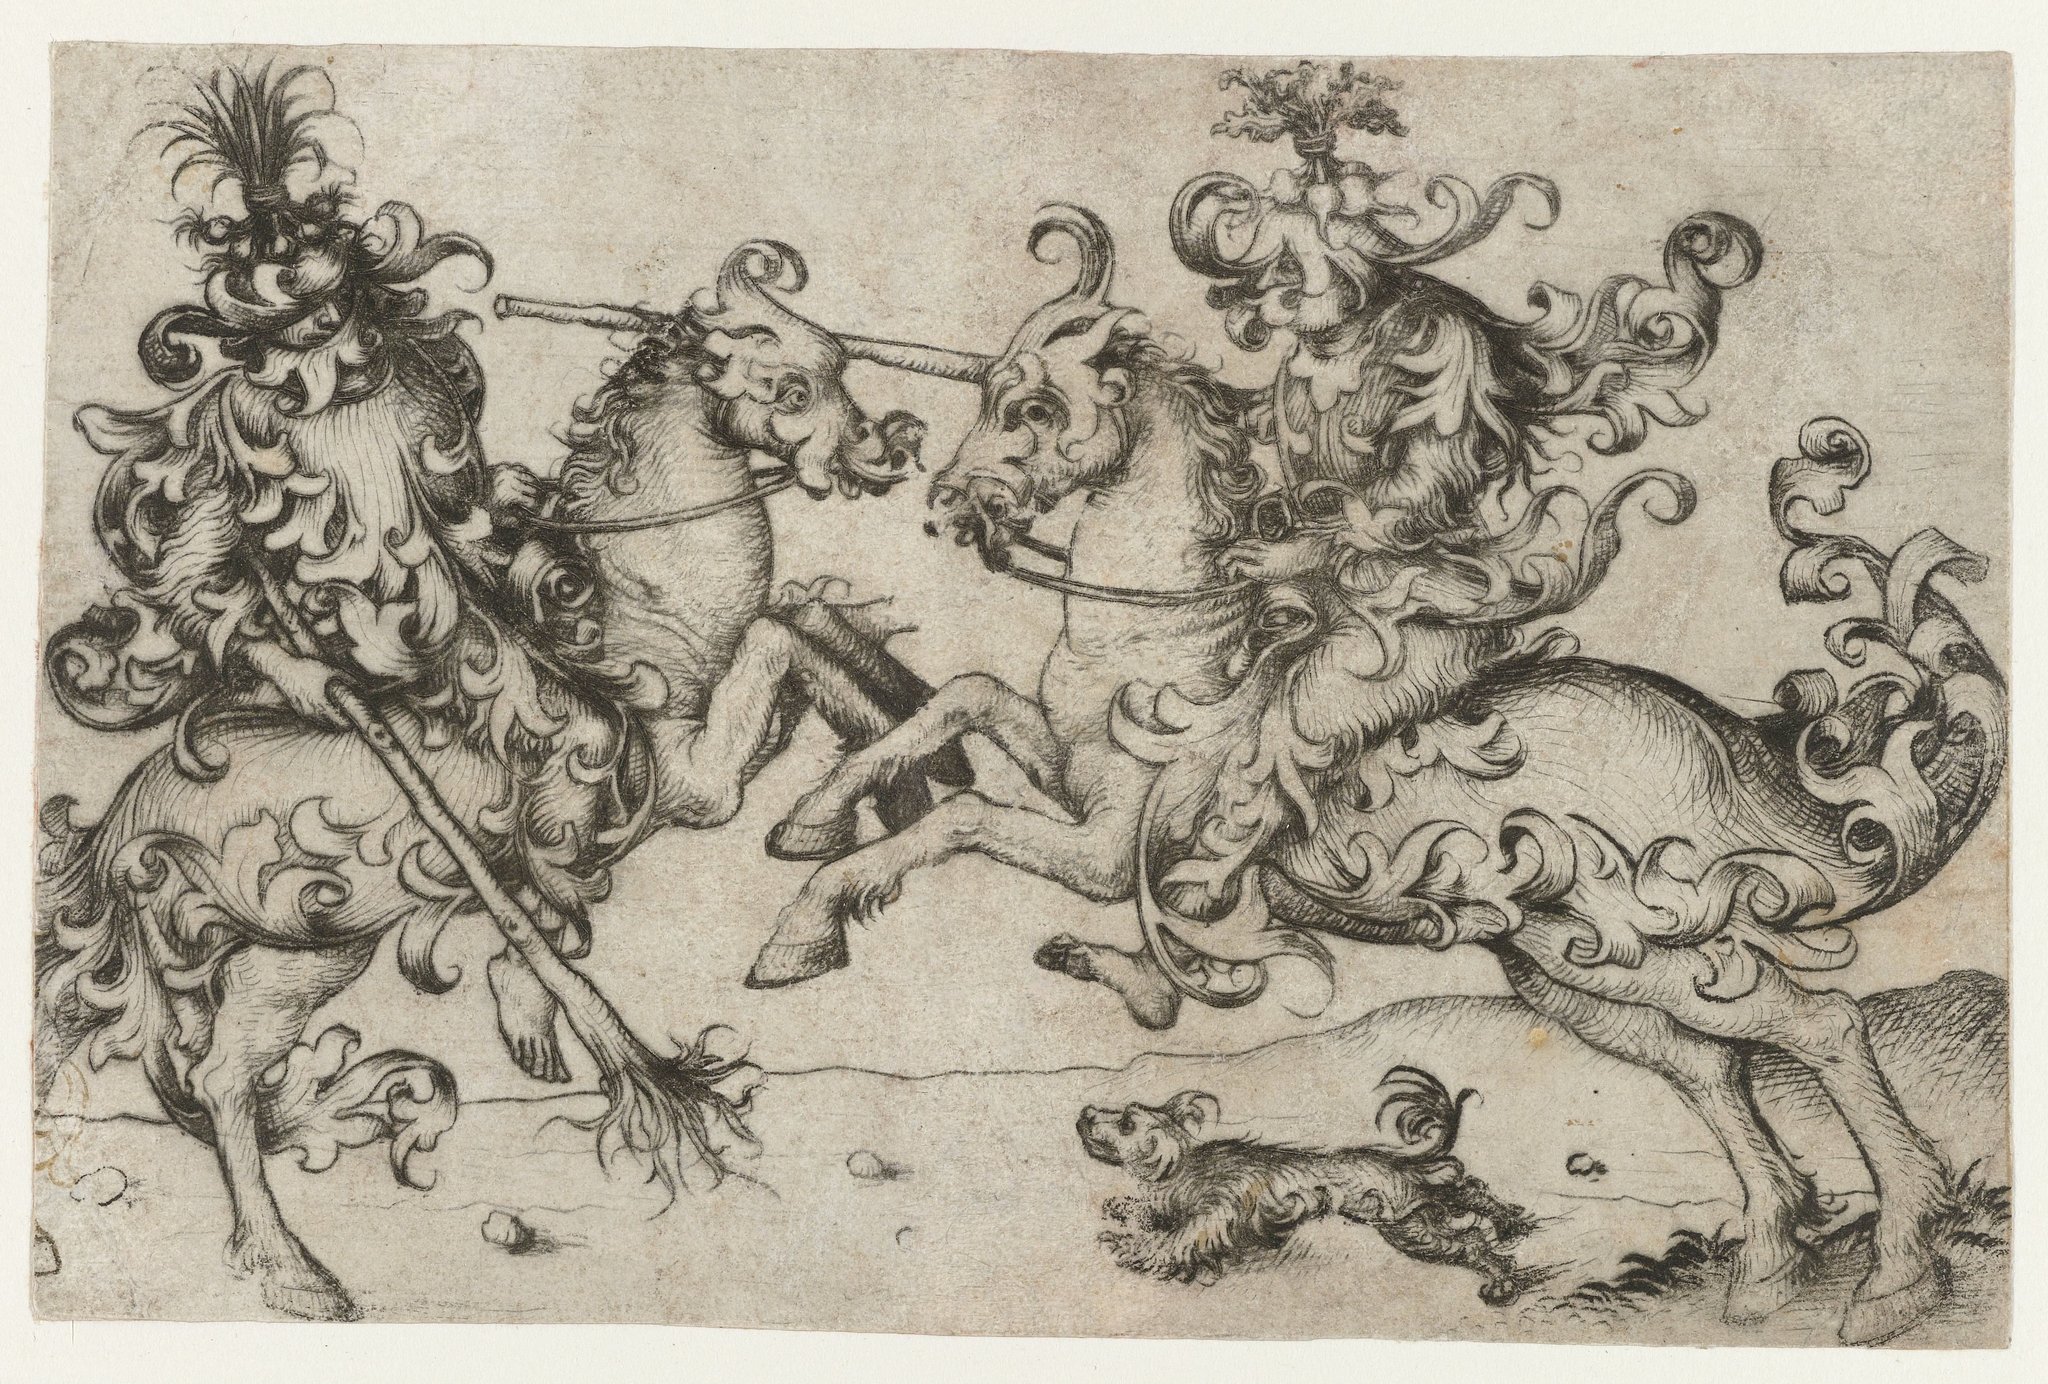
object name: print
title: Gevecht tussen twee wildemannen te paard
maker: meester van het amsterdamse kabinet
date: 1475-1480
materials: paper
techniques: drypoint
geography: germany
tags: wild man, wodewose, woodehouse, plants; vegetation (+ ornamental variants of plants), (medieval) fighting contest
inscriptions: collector's mark: Lugt 2228a, collector's mark: Lugt 240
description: Twee ruiters die elkaar met uit de grond gerukte bomen te lijf gaan. Hun harnas en het kleed van de paarden bestaat uit ornamenteel bladwerk, de helmen zijn een respectievelijk een bosje knoflook en een bosje radijzen.